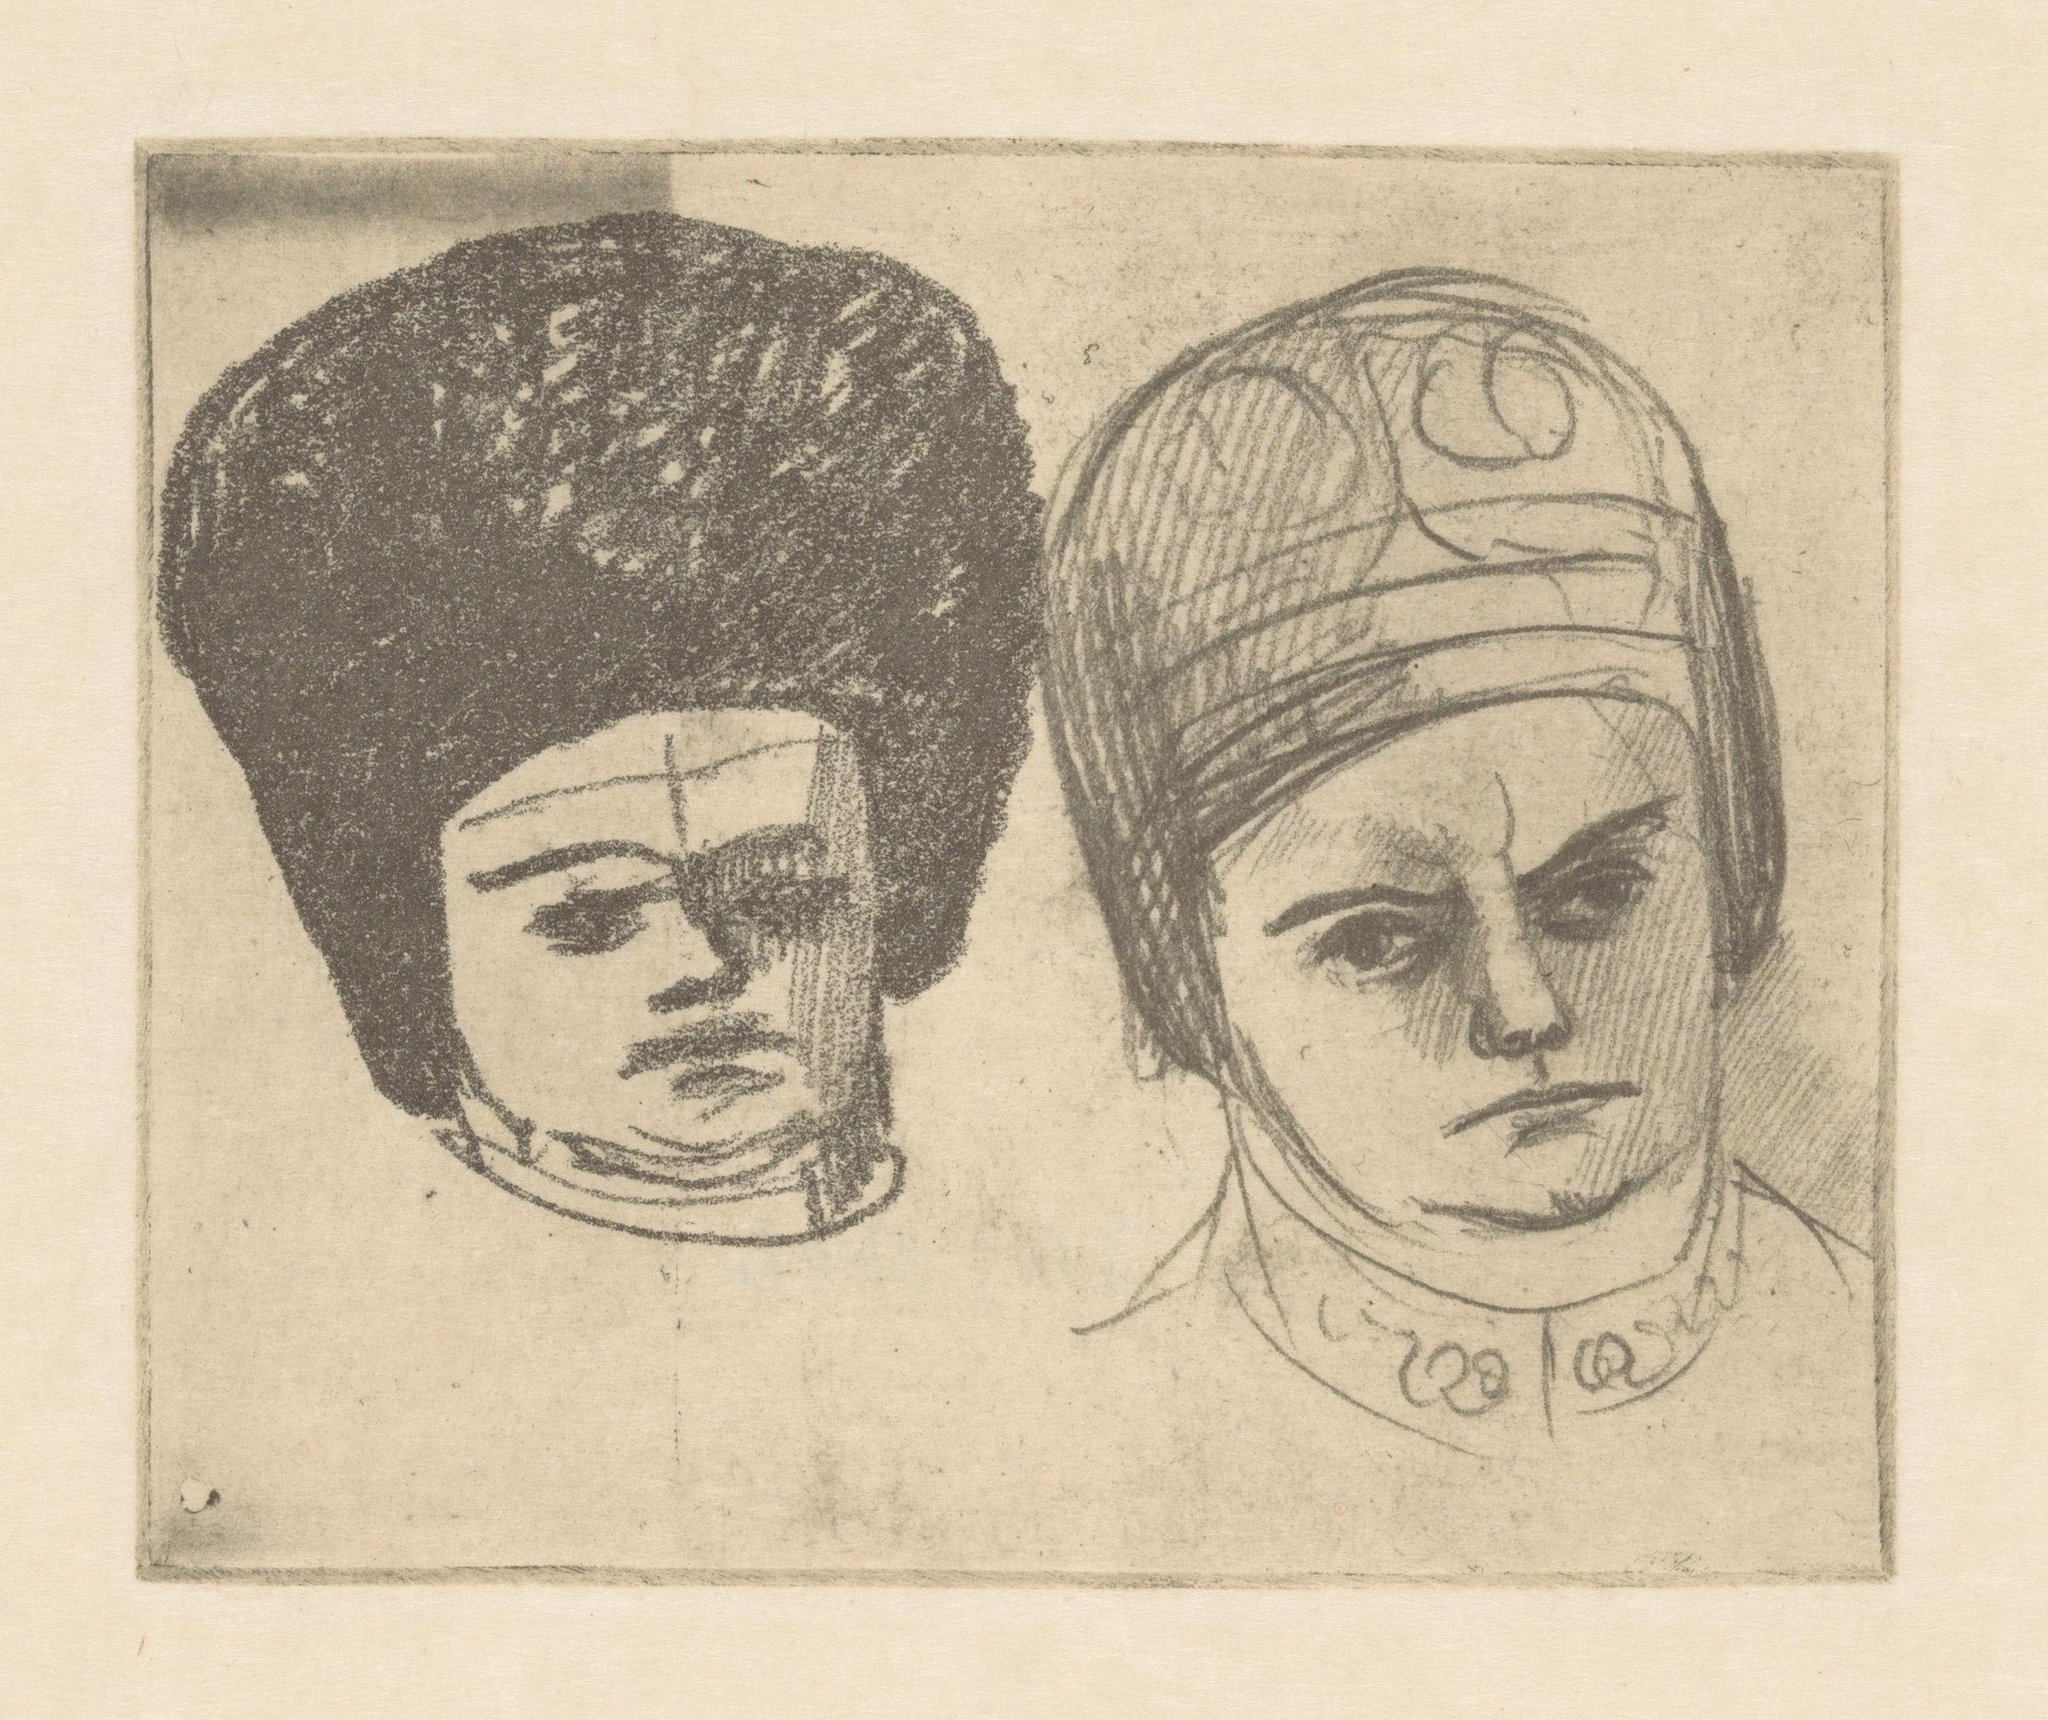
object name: print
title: Twee soldaten met kolbak en helm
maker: marius holleman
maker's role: draughtsman, print maker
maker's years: 1878-1926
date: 1904-1926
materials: paper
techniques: etching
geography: groningen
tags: helmet, head-gear (with name)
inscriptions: collector's mark: Lugt 2228